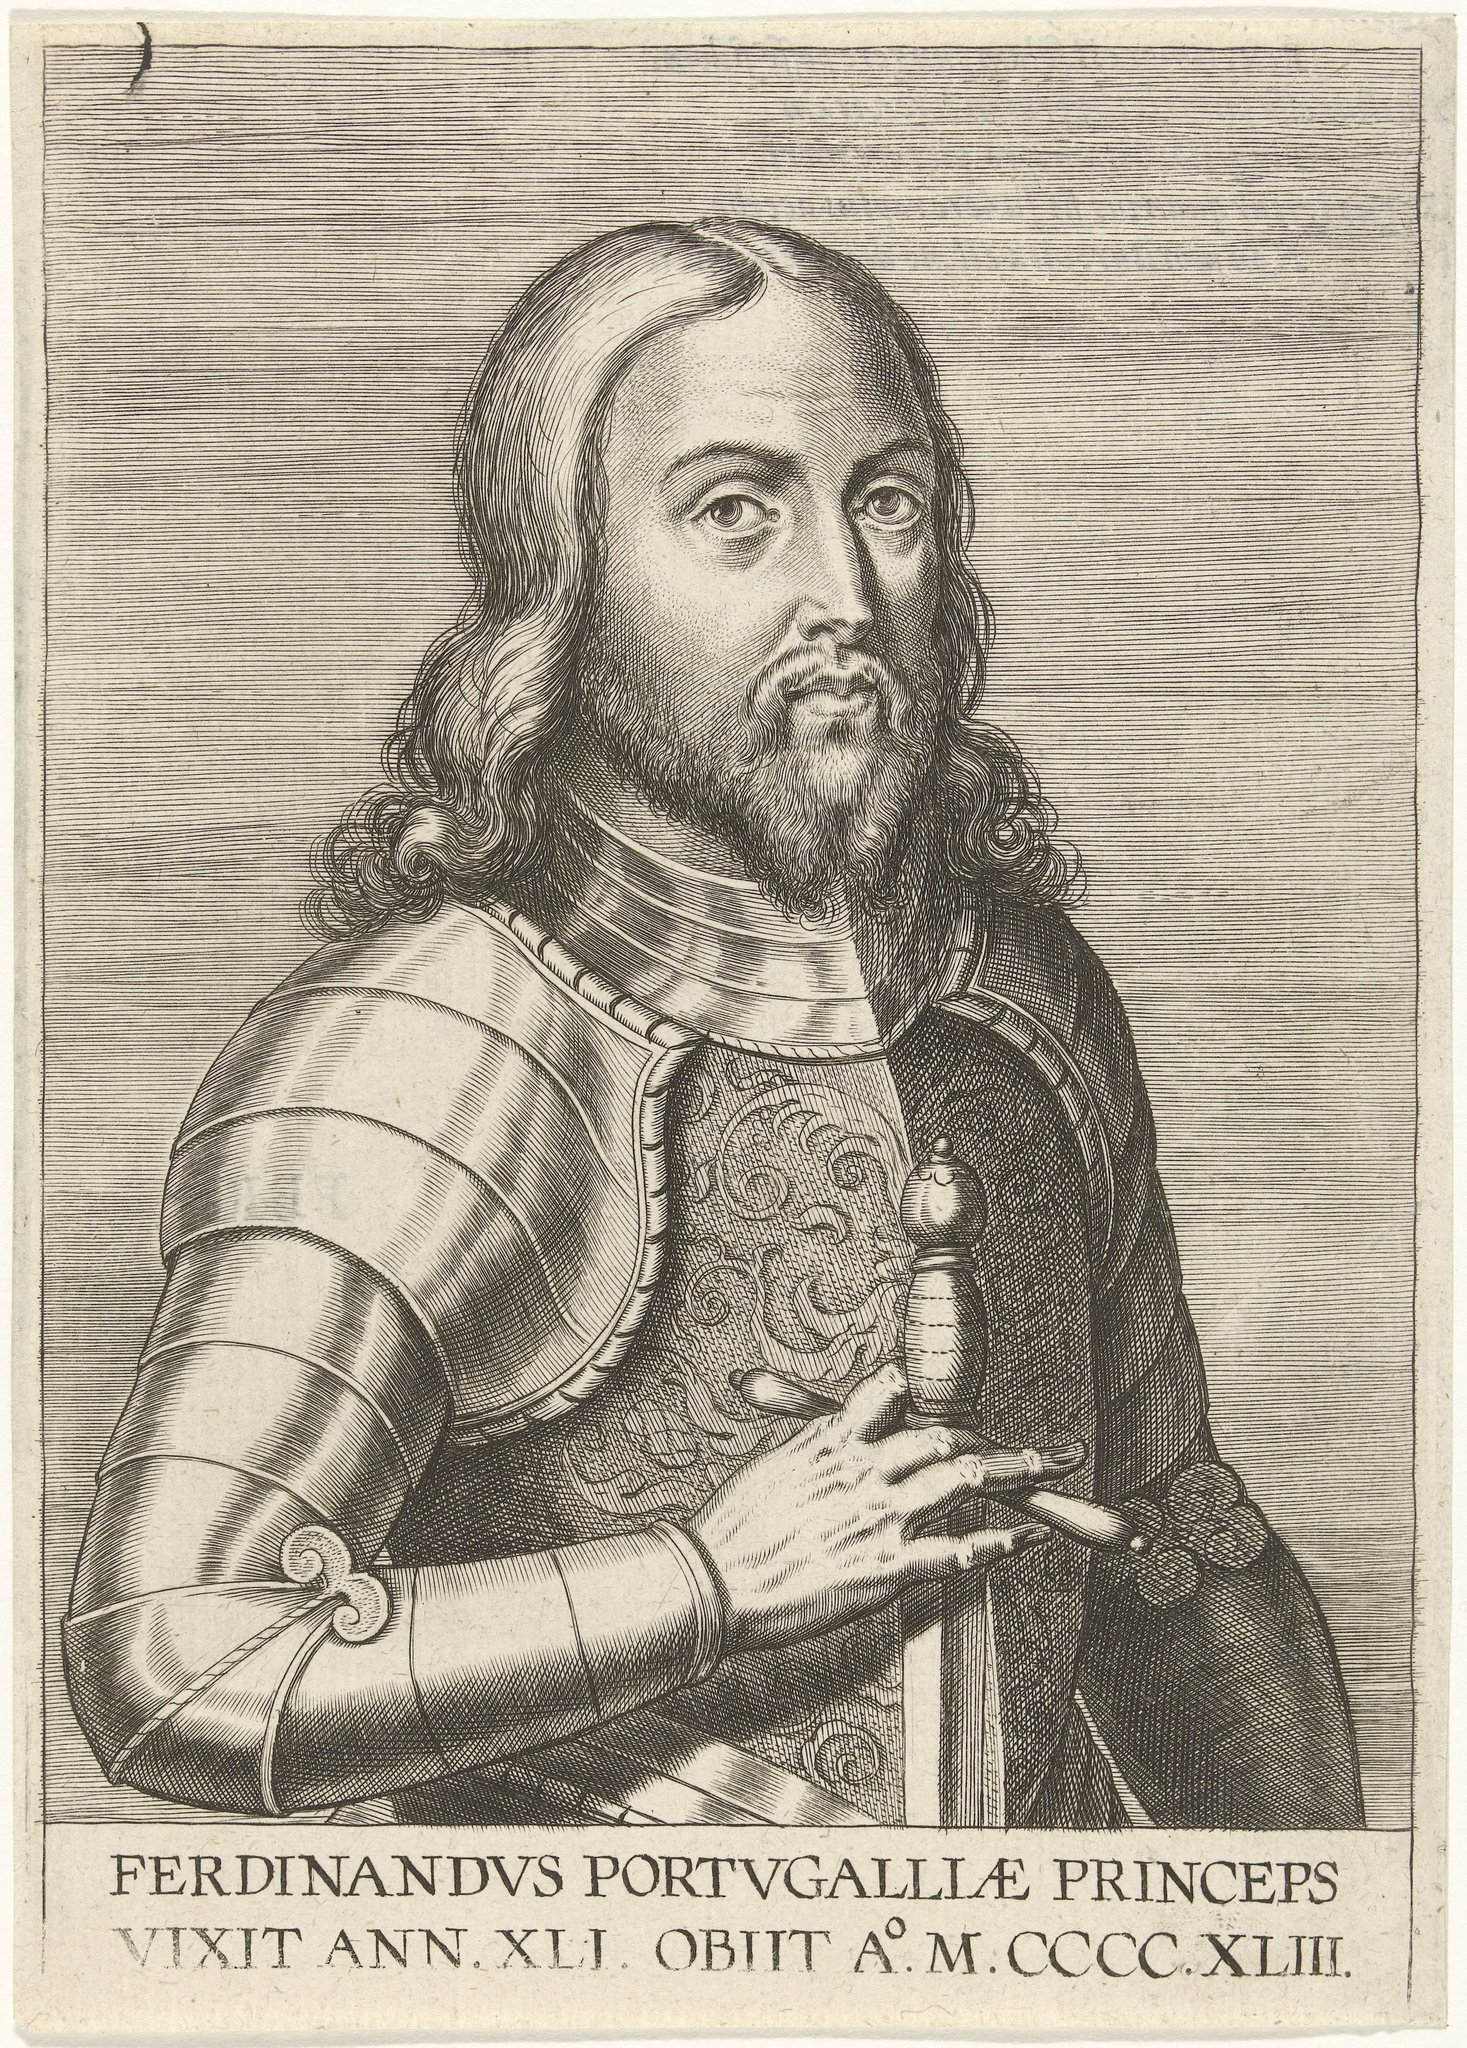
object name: book illustration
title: Portret van Ferdinand van Portugal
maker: cornelis galle (i)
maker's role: print maker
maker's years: 1576-1650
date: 1621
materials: paper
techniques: engraving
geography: southern netherlands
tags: ridder, ferdinand van portugal, portugal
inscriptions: collector's mark: Lugt 2228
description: Illustratie voor: Antonio Vasconcellos. Anacephalæoses id est, Svmma captia actorvm regvm Lvsitaniæ. Antwerpen: Petrus II en Joannes II Bellerus, 1621.